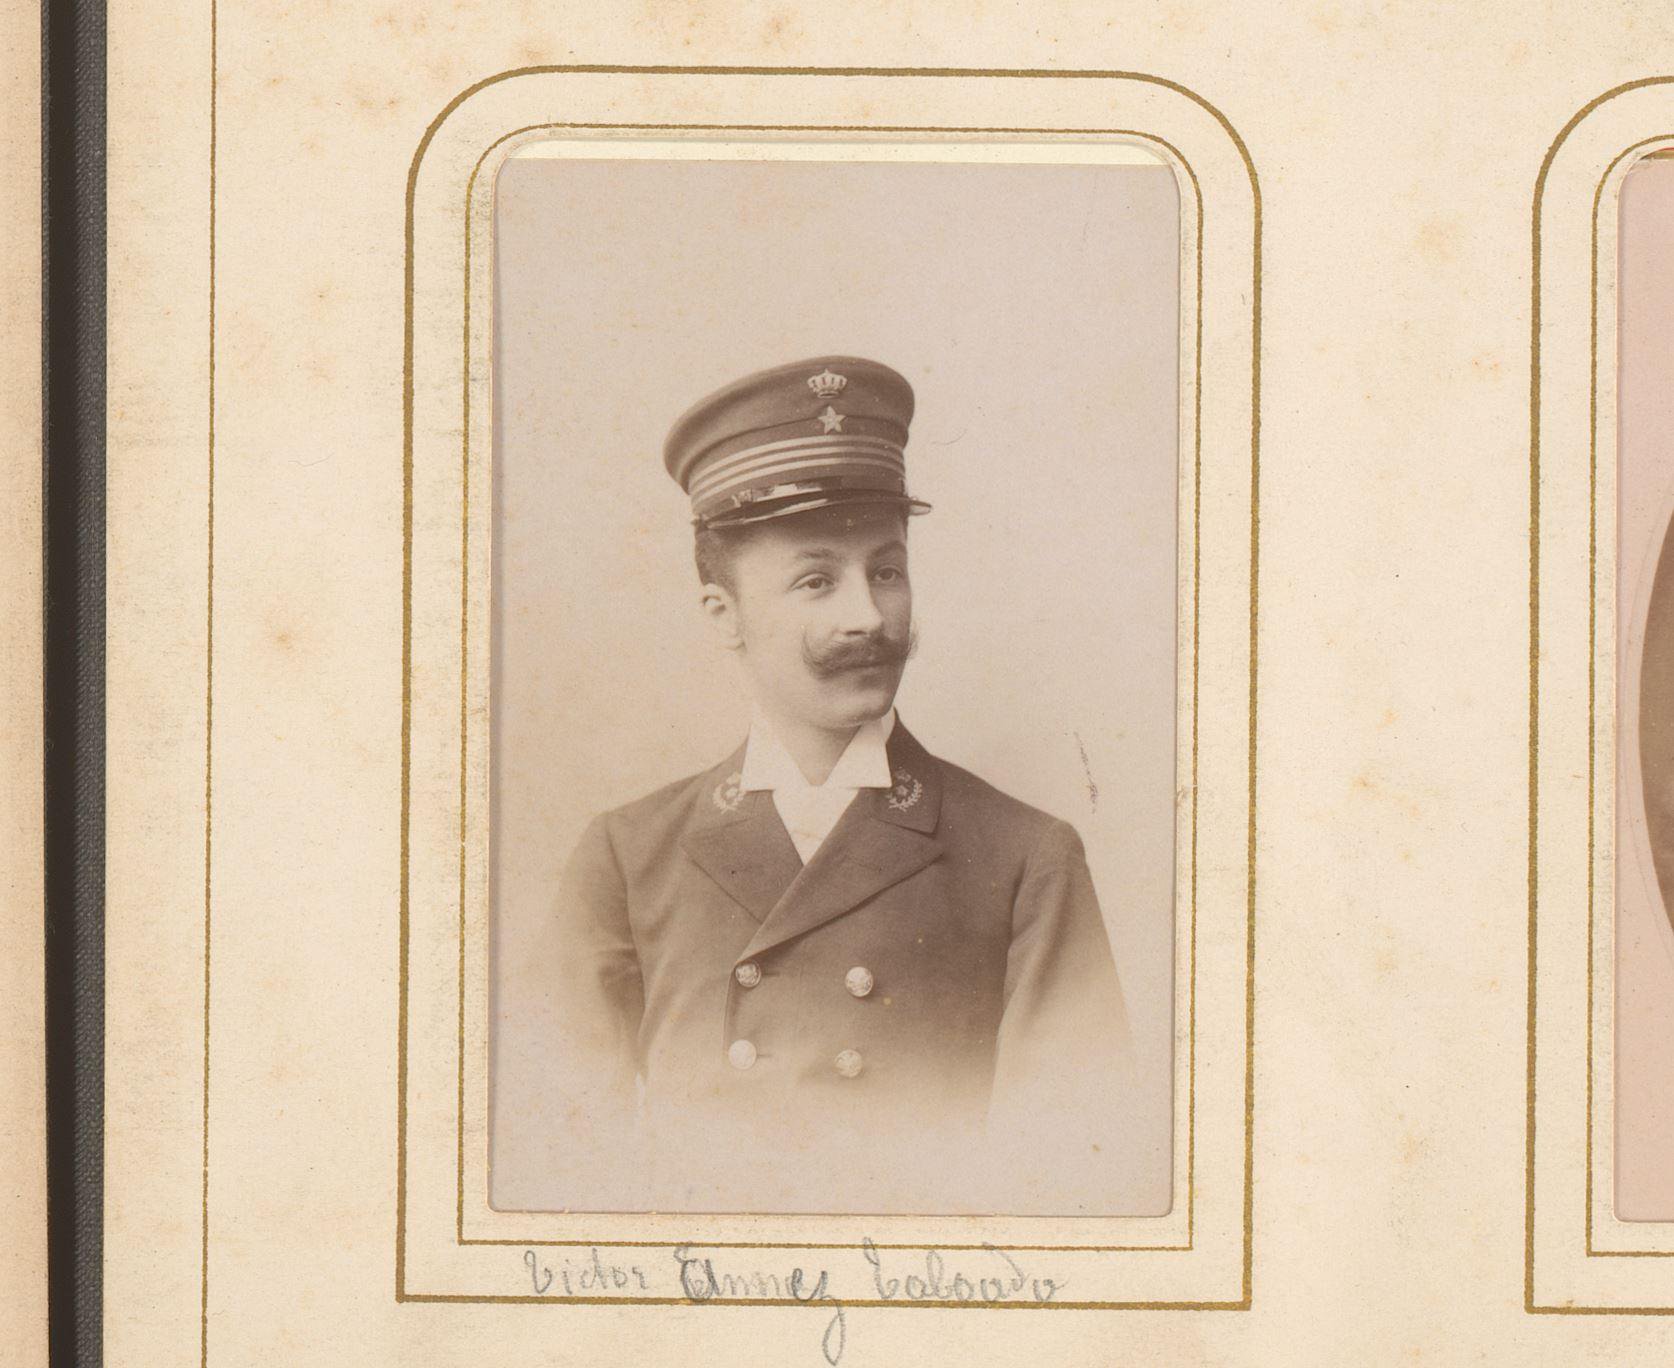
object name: album leaf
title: Portret van een man met snor in uniform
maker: edouard fabronius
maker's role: fotograaf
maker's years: 1847-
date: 1891-1900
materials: cardboard, photographic support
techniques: albumen print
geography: brussels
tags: moustache, historical persons, (military) uniforms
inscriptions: inscription: ‘Fabronius/ Photographe/ 11/ Rue Neuve,/ Bruxelles./ Les clichés sont conservés.’, name: ‘Vidor Annez [.]aboa[d]o’